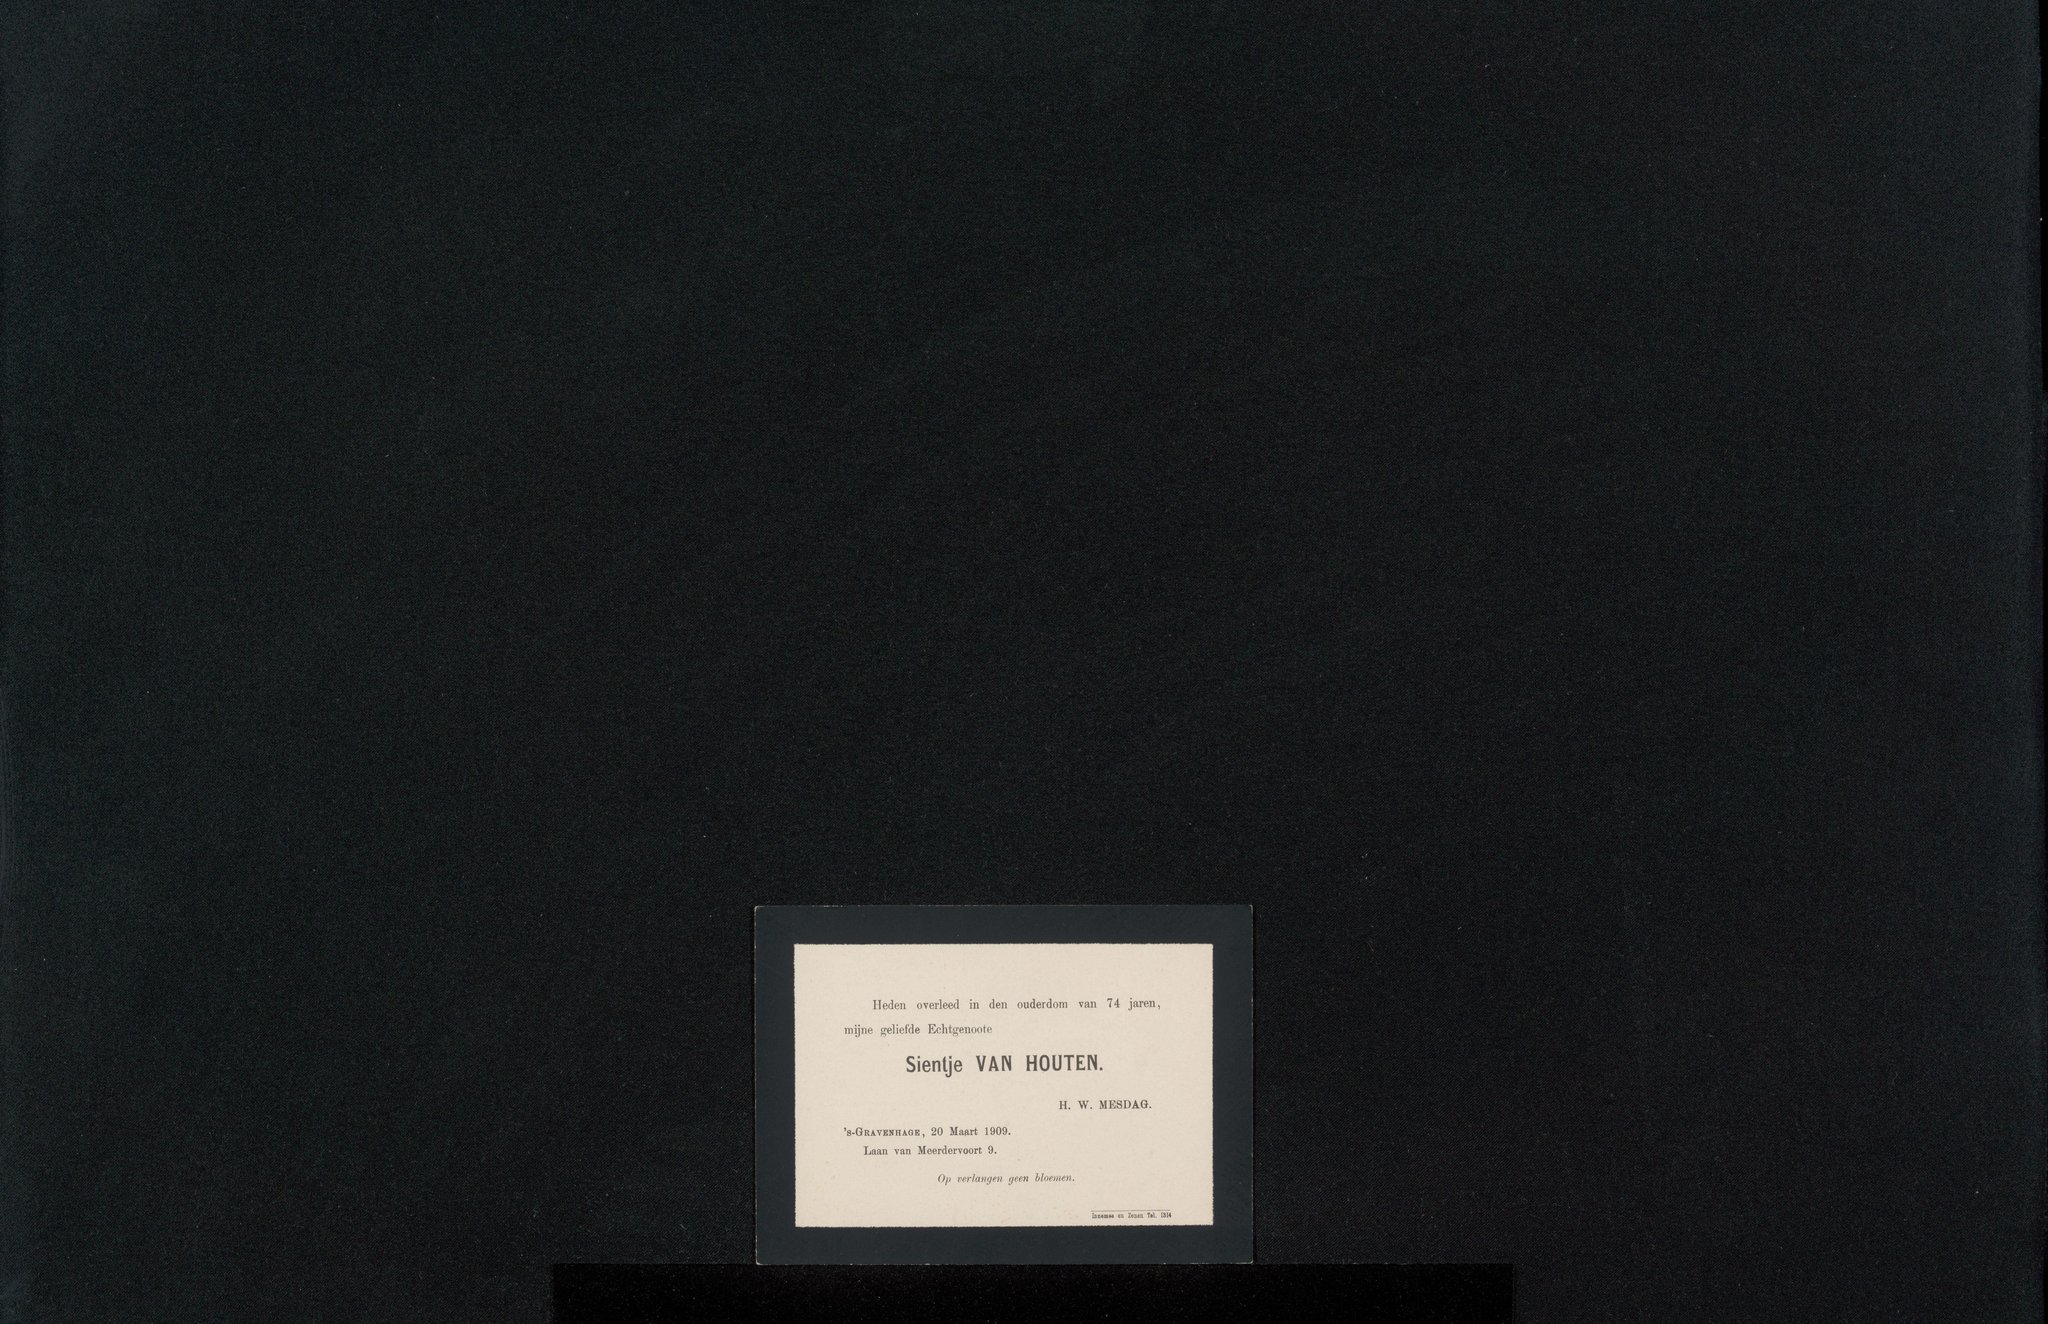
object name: overlijdensbericht, overlijdensadvertentie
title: Overlijdensbericht aan Philip Zilcken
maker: Anonymous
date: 1909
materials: cardboard, ink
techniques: printing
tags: sientje mesdag-van houten, painter, draughtsman, philip zilcken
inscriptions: collector's mark: ‘RPK’